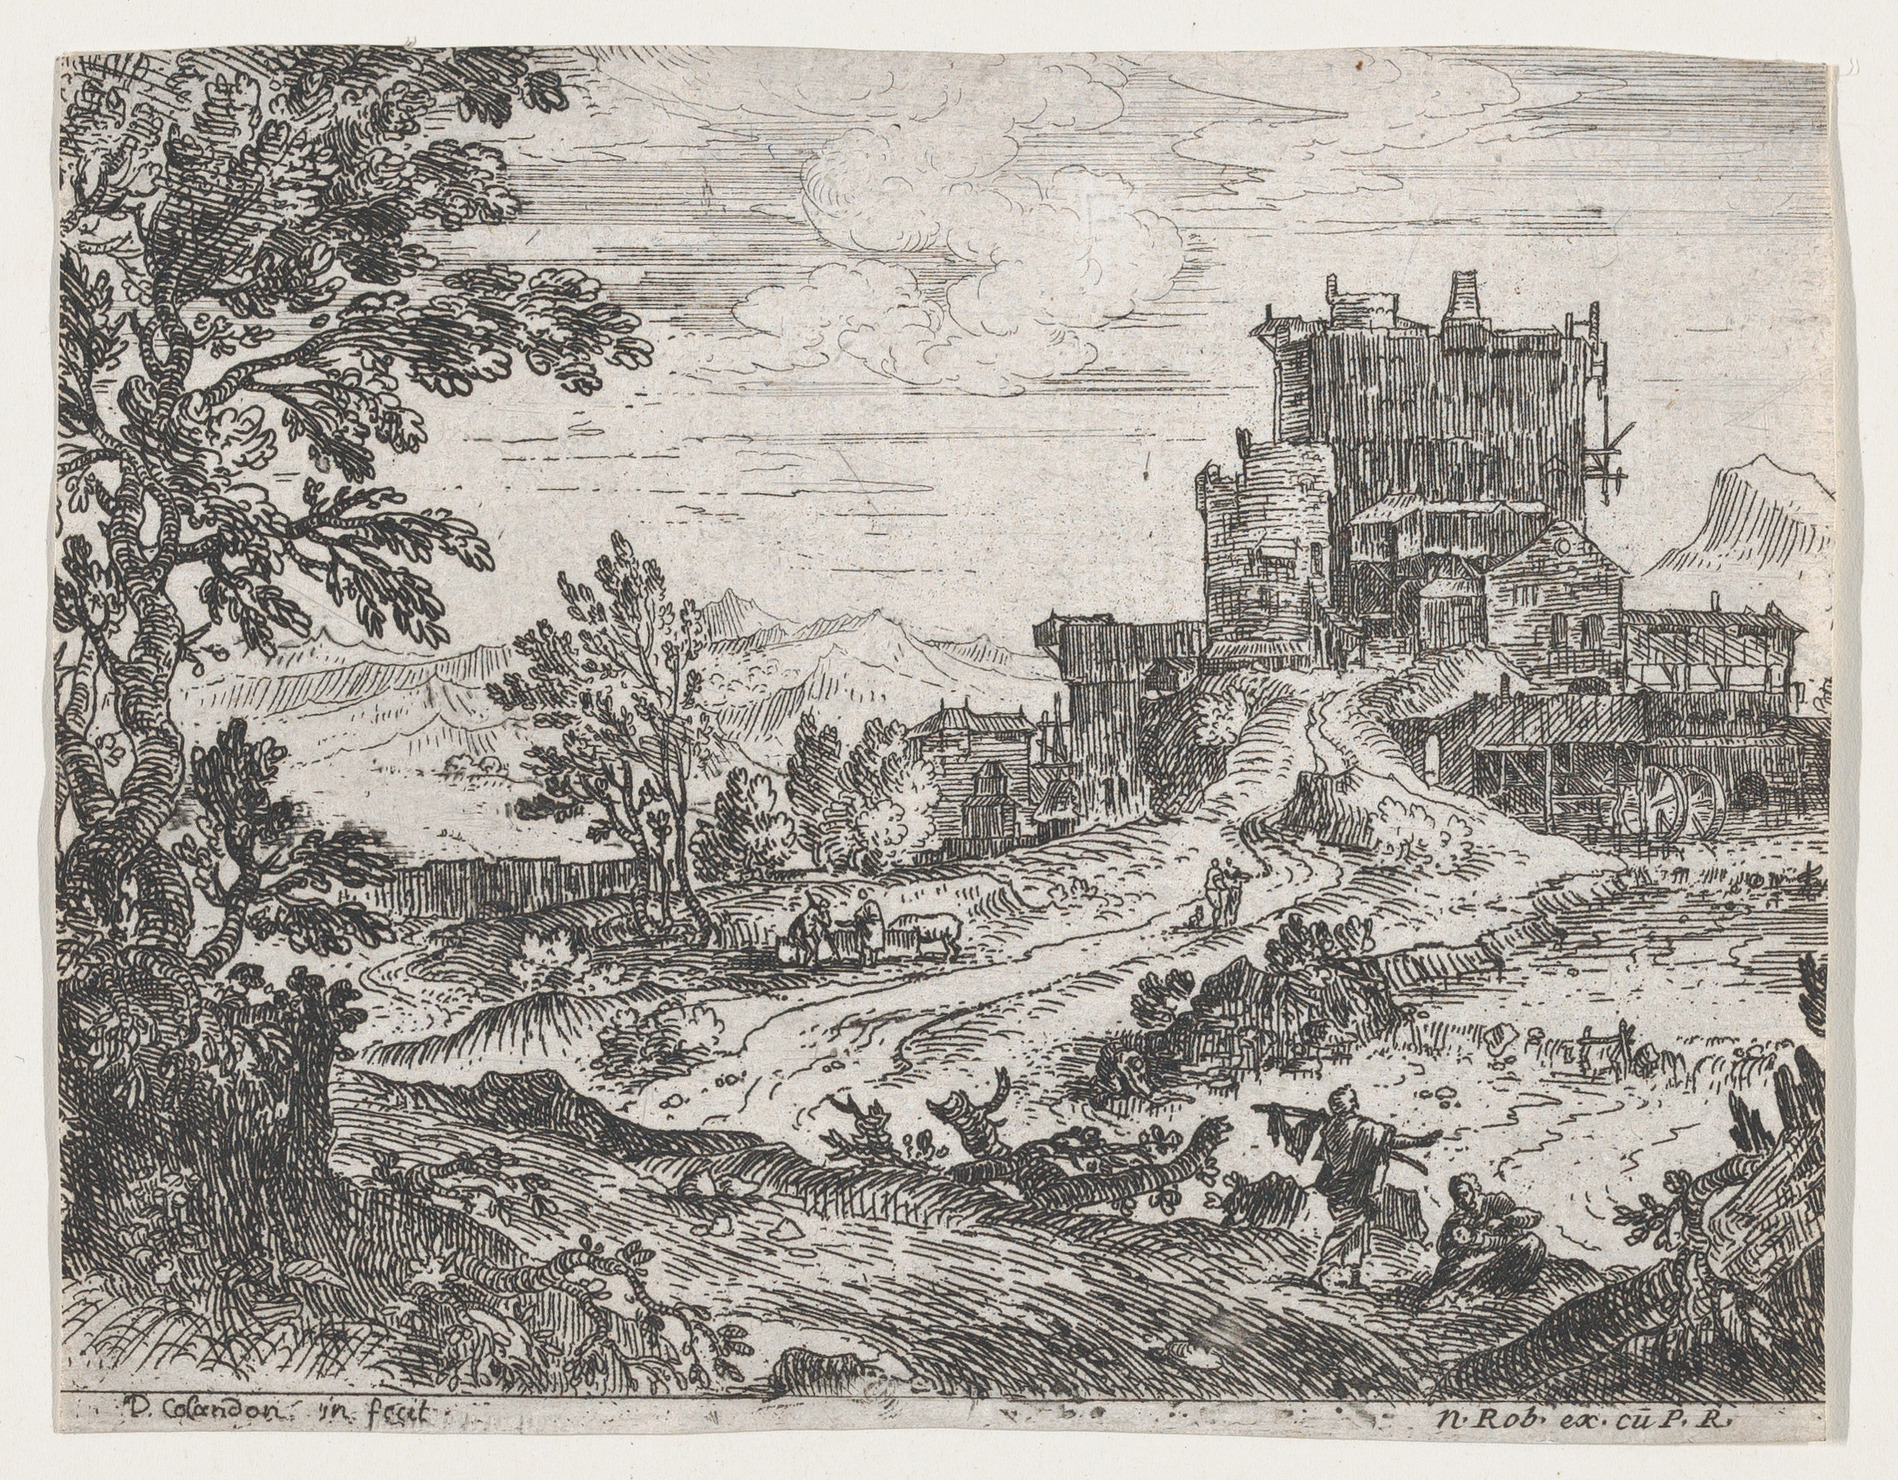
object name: print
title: The Nurse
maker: denis colandon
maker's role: artist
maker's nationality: french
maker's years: 1600-1700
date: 1674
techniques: etching